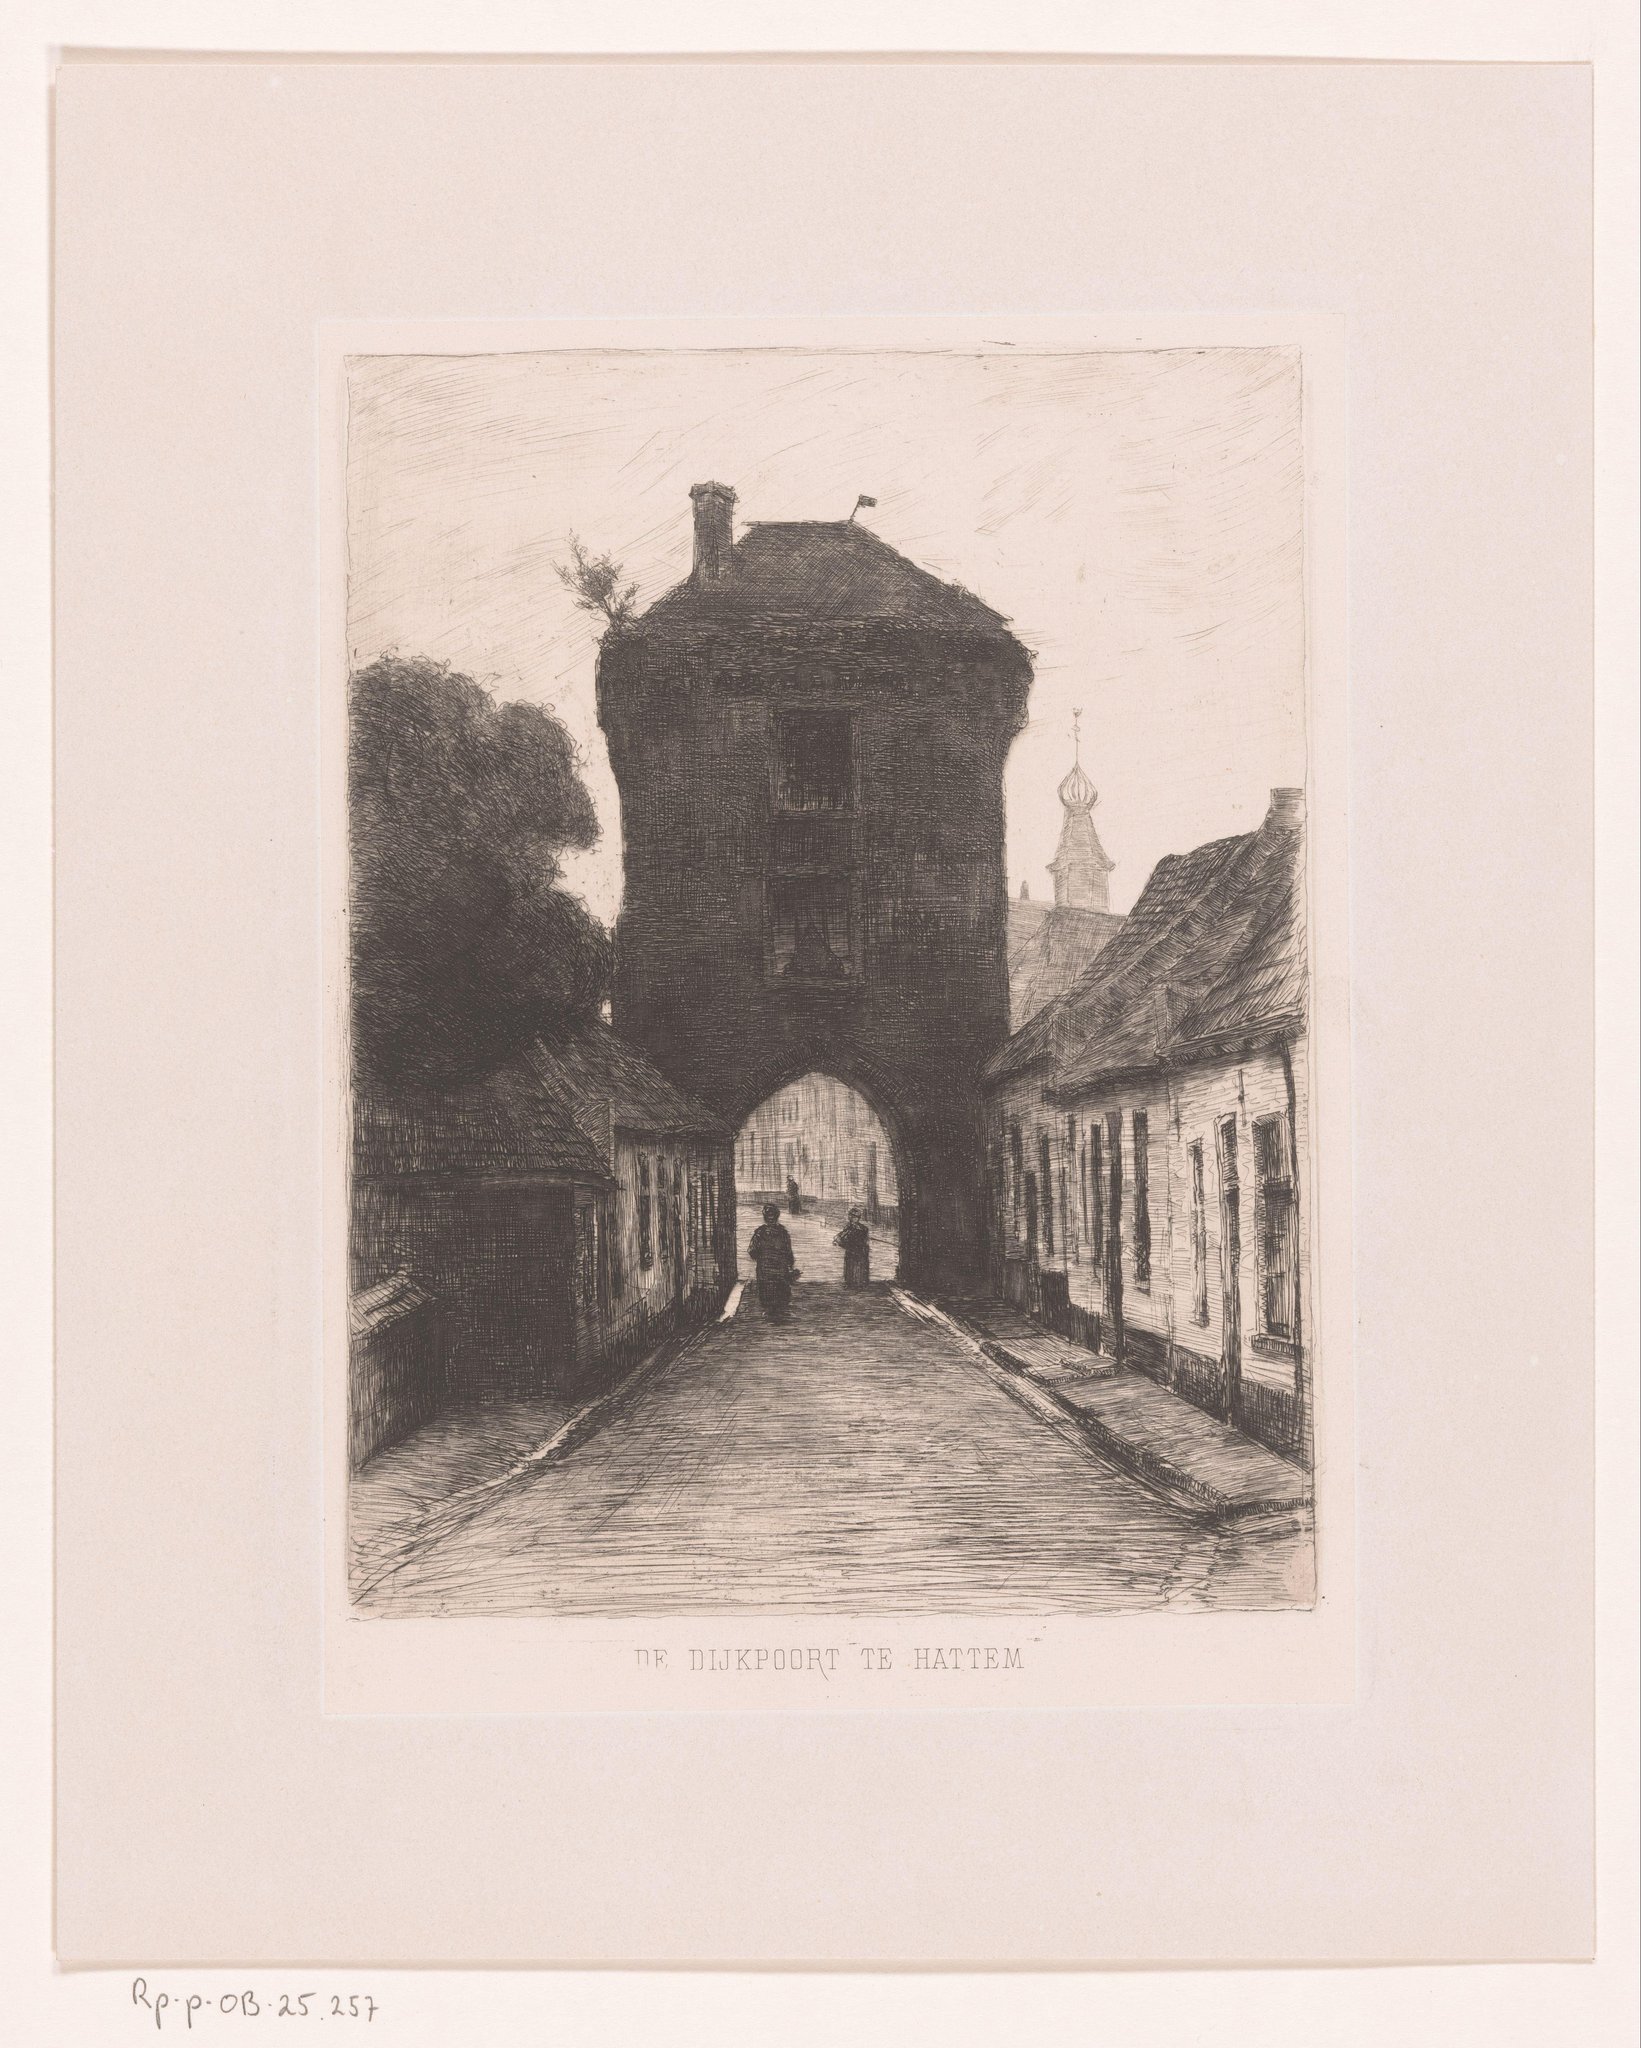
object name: print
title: De Dijkspoort te Hattem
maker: jan hillebrand wijsmuller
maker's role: painter, print maker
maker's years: 1855-1925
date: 1865-1908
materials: paper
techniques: etching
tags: city-gate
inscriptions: collector's mark: Lugt 2228, inscription: ‘Distel 1887’